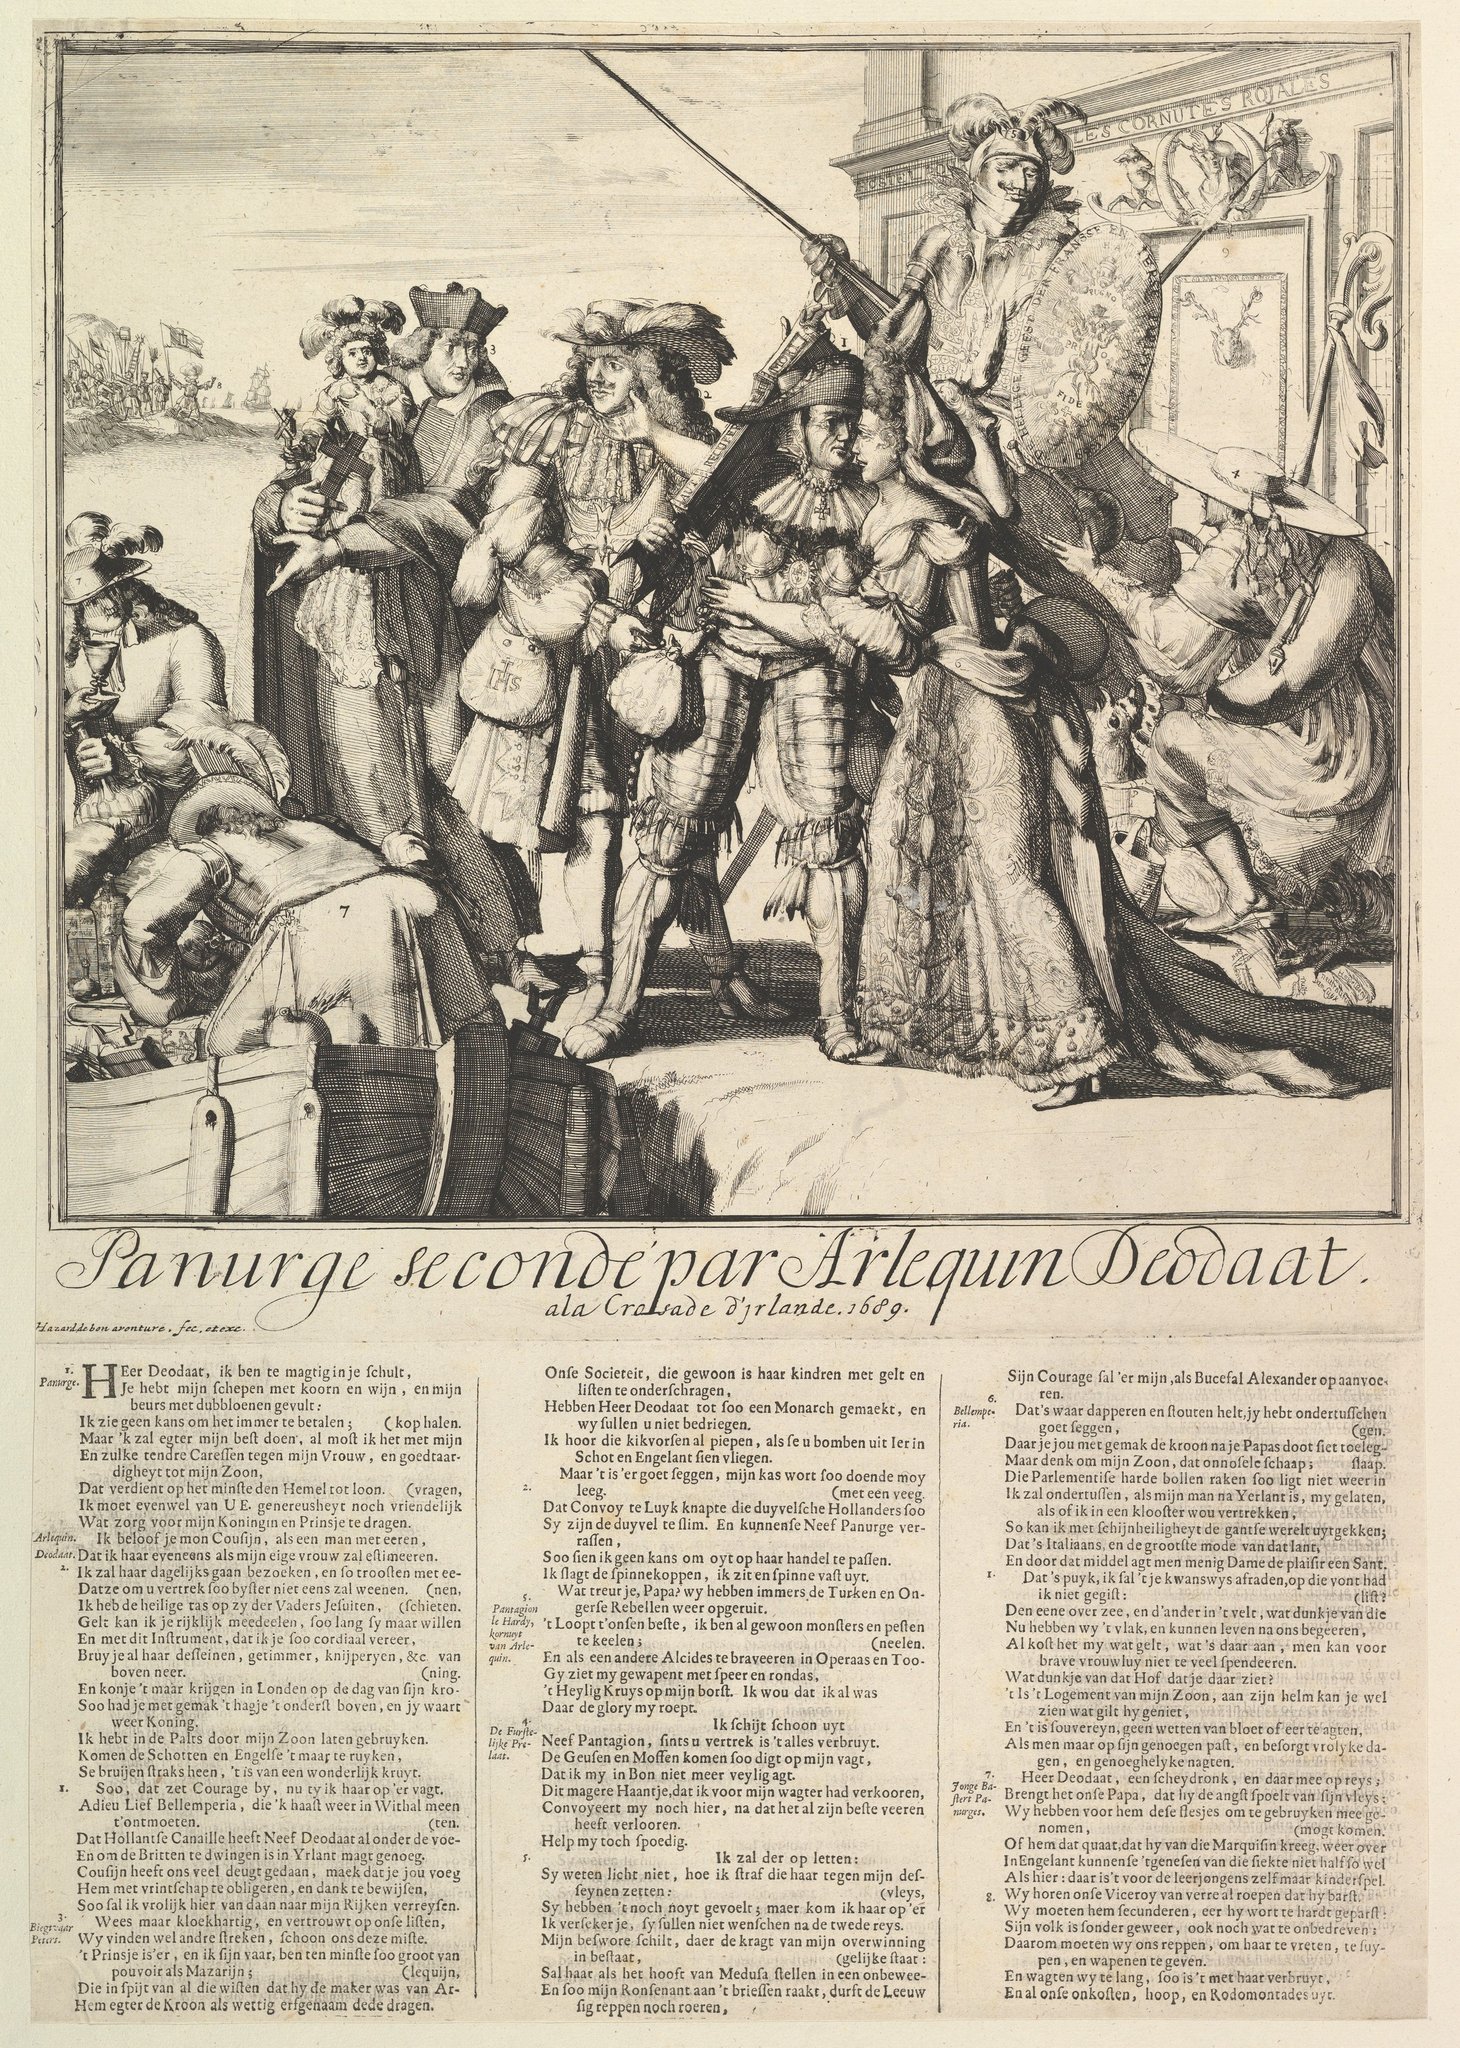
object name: print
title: Panurge secondé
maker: romeyn de hooghe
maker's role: artist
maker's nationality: dutch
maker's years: 1645-1708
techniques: etching, letterpress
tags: men,women